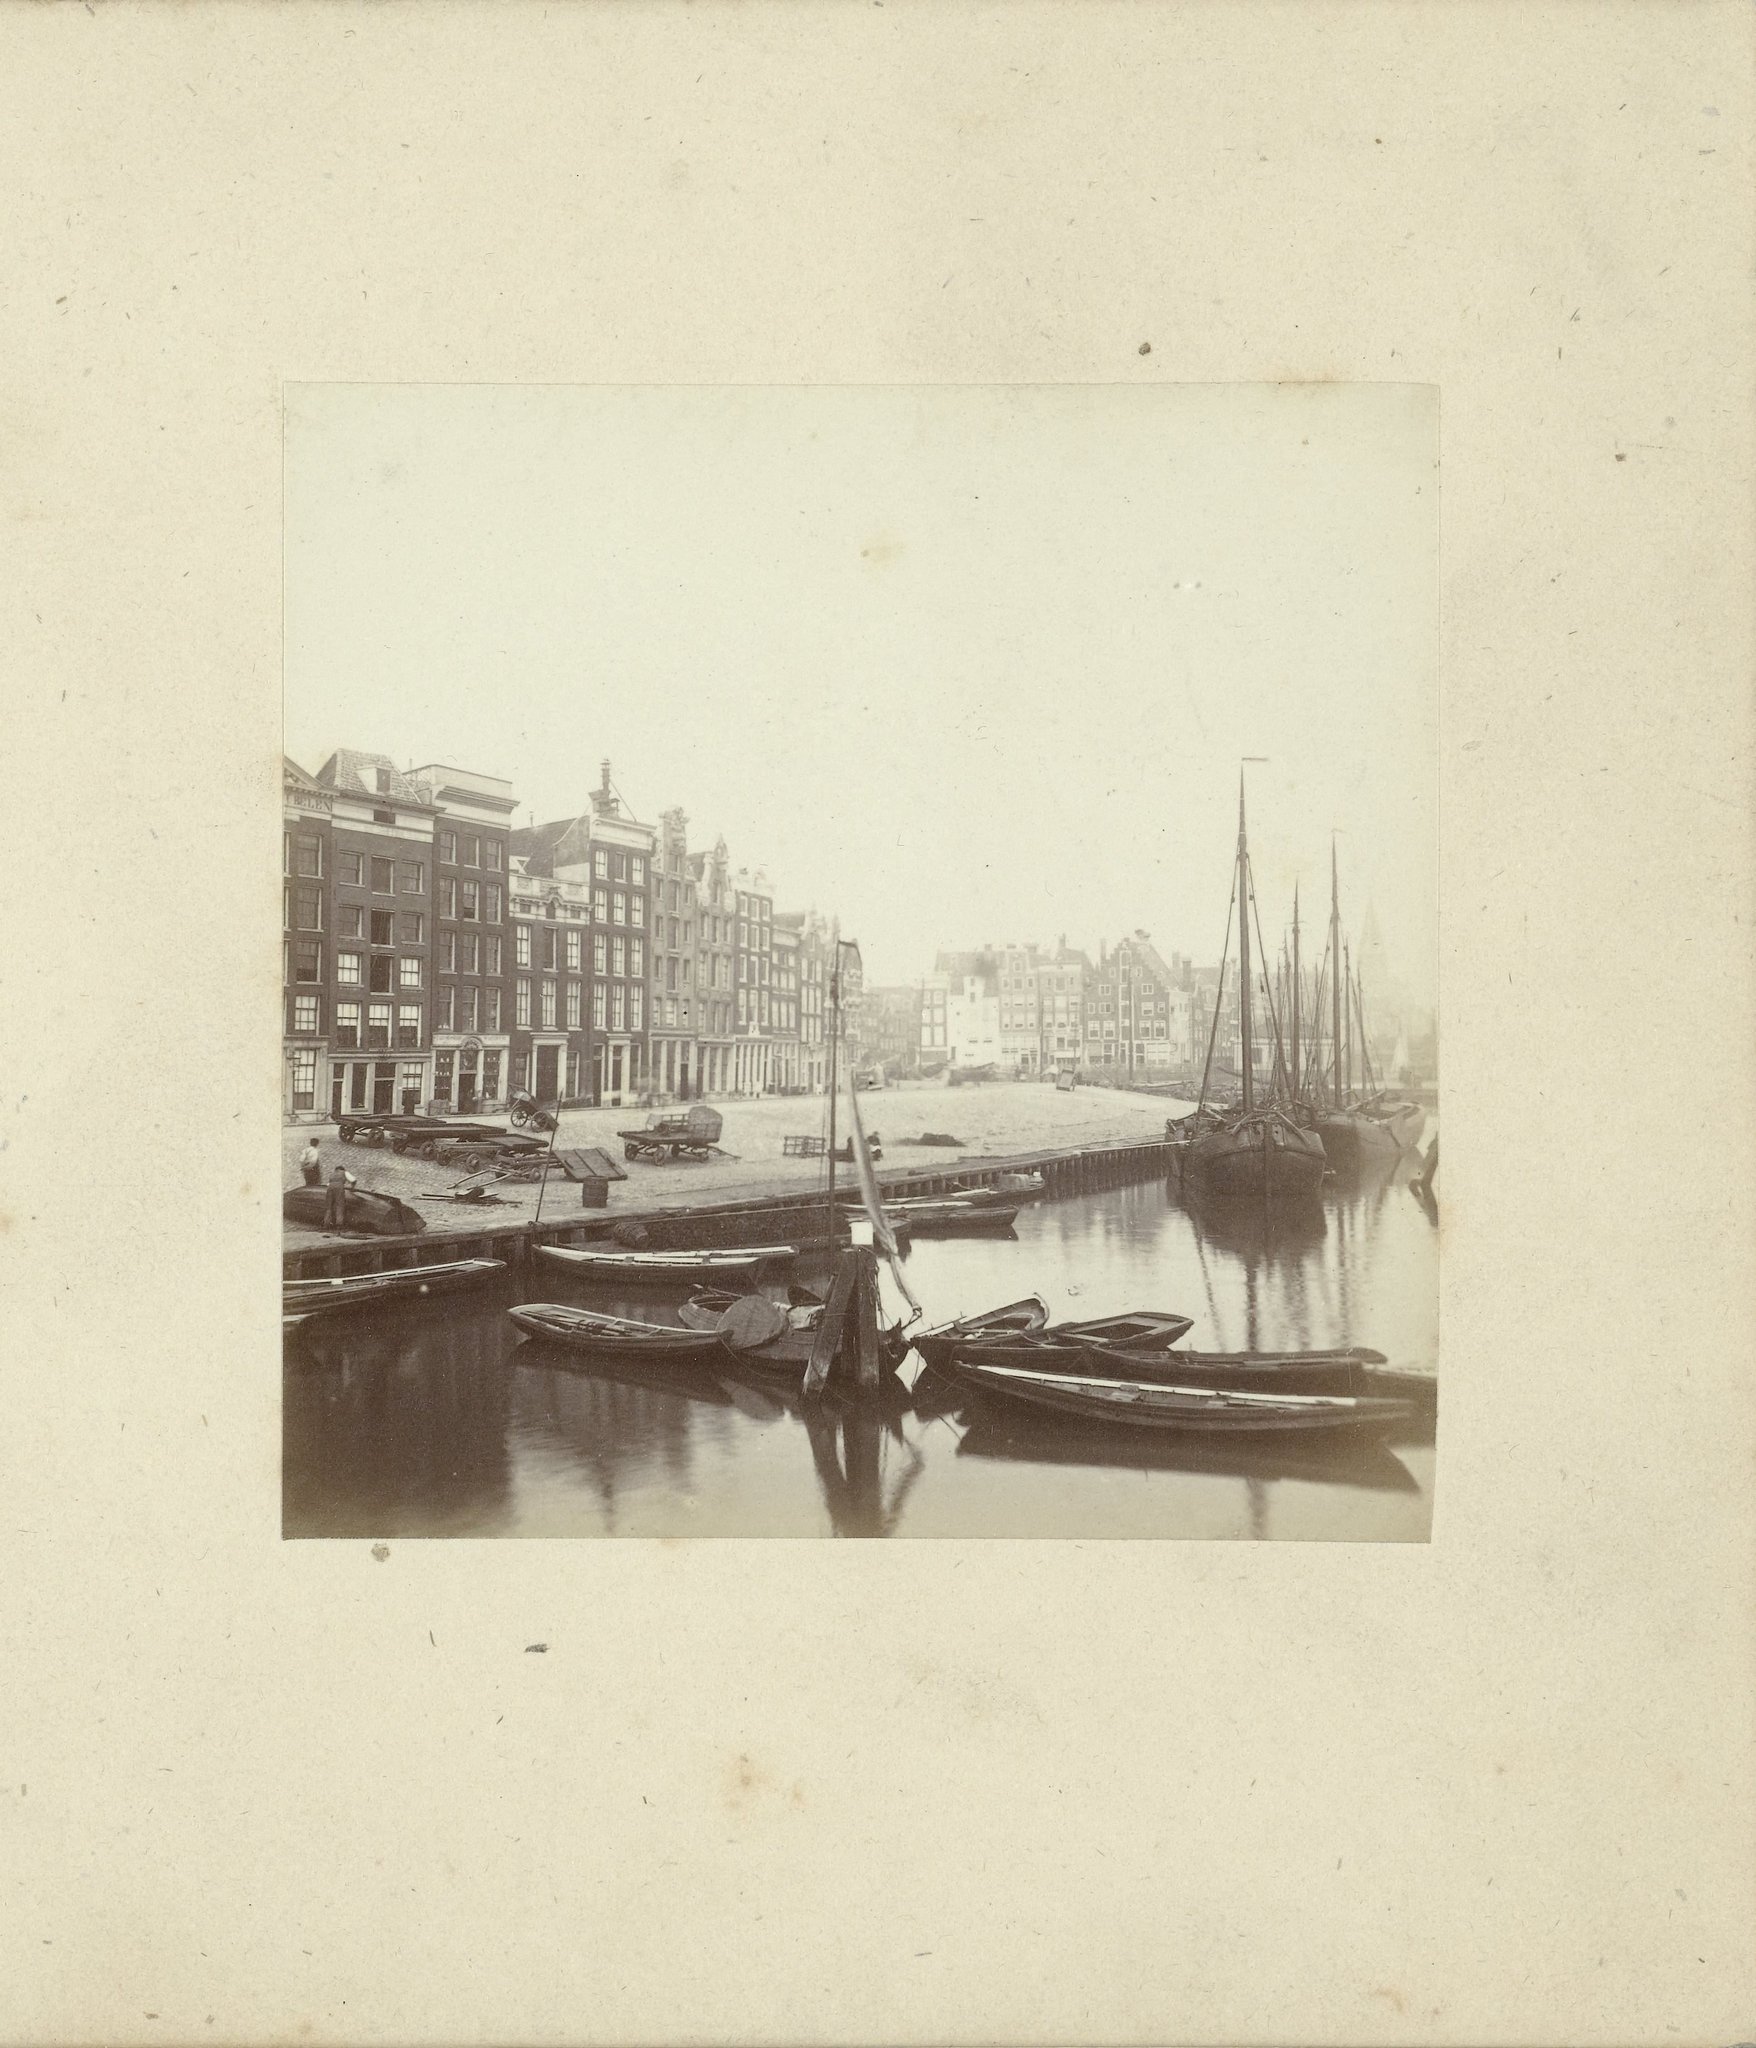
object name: photograph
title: De Haringpakkerij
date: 1860-1875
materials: cardboard, paper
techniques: albumen print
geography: amsterdam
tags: quay